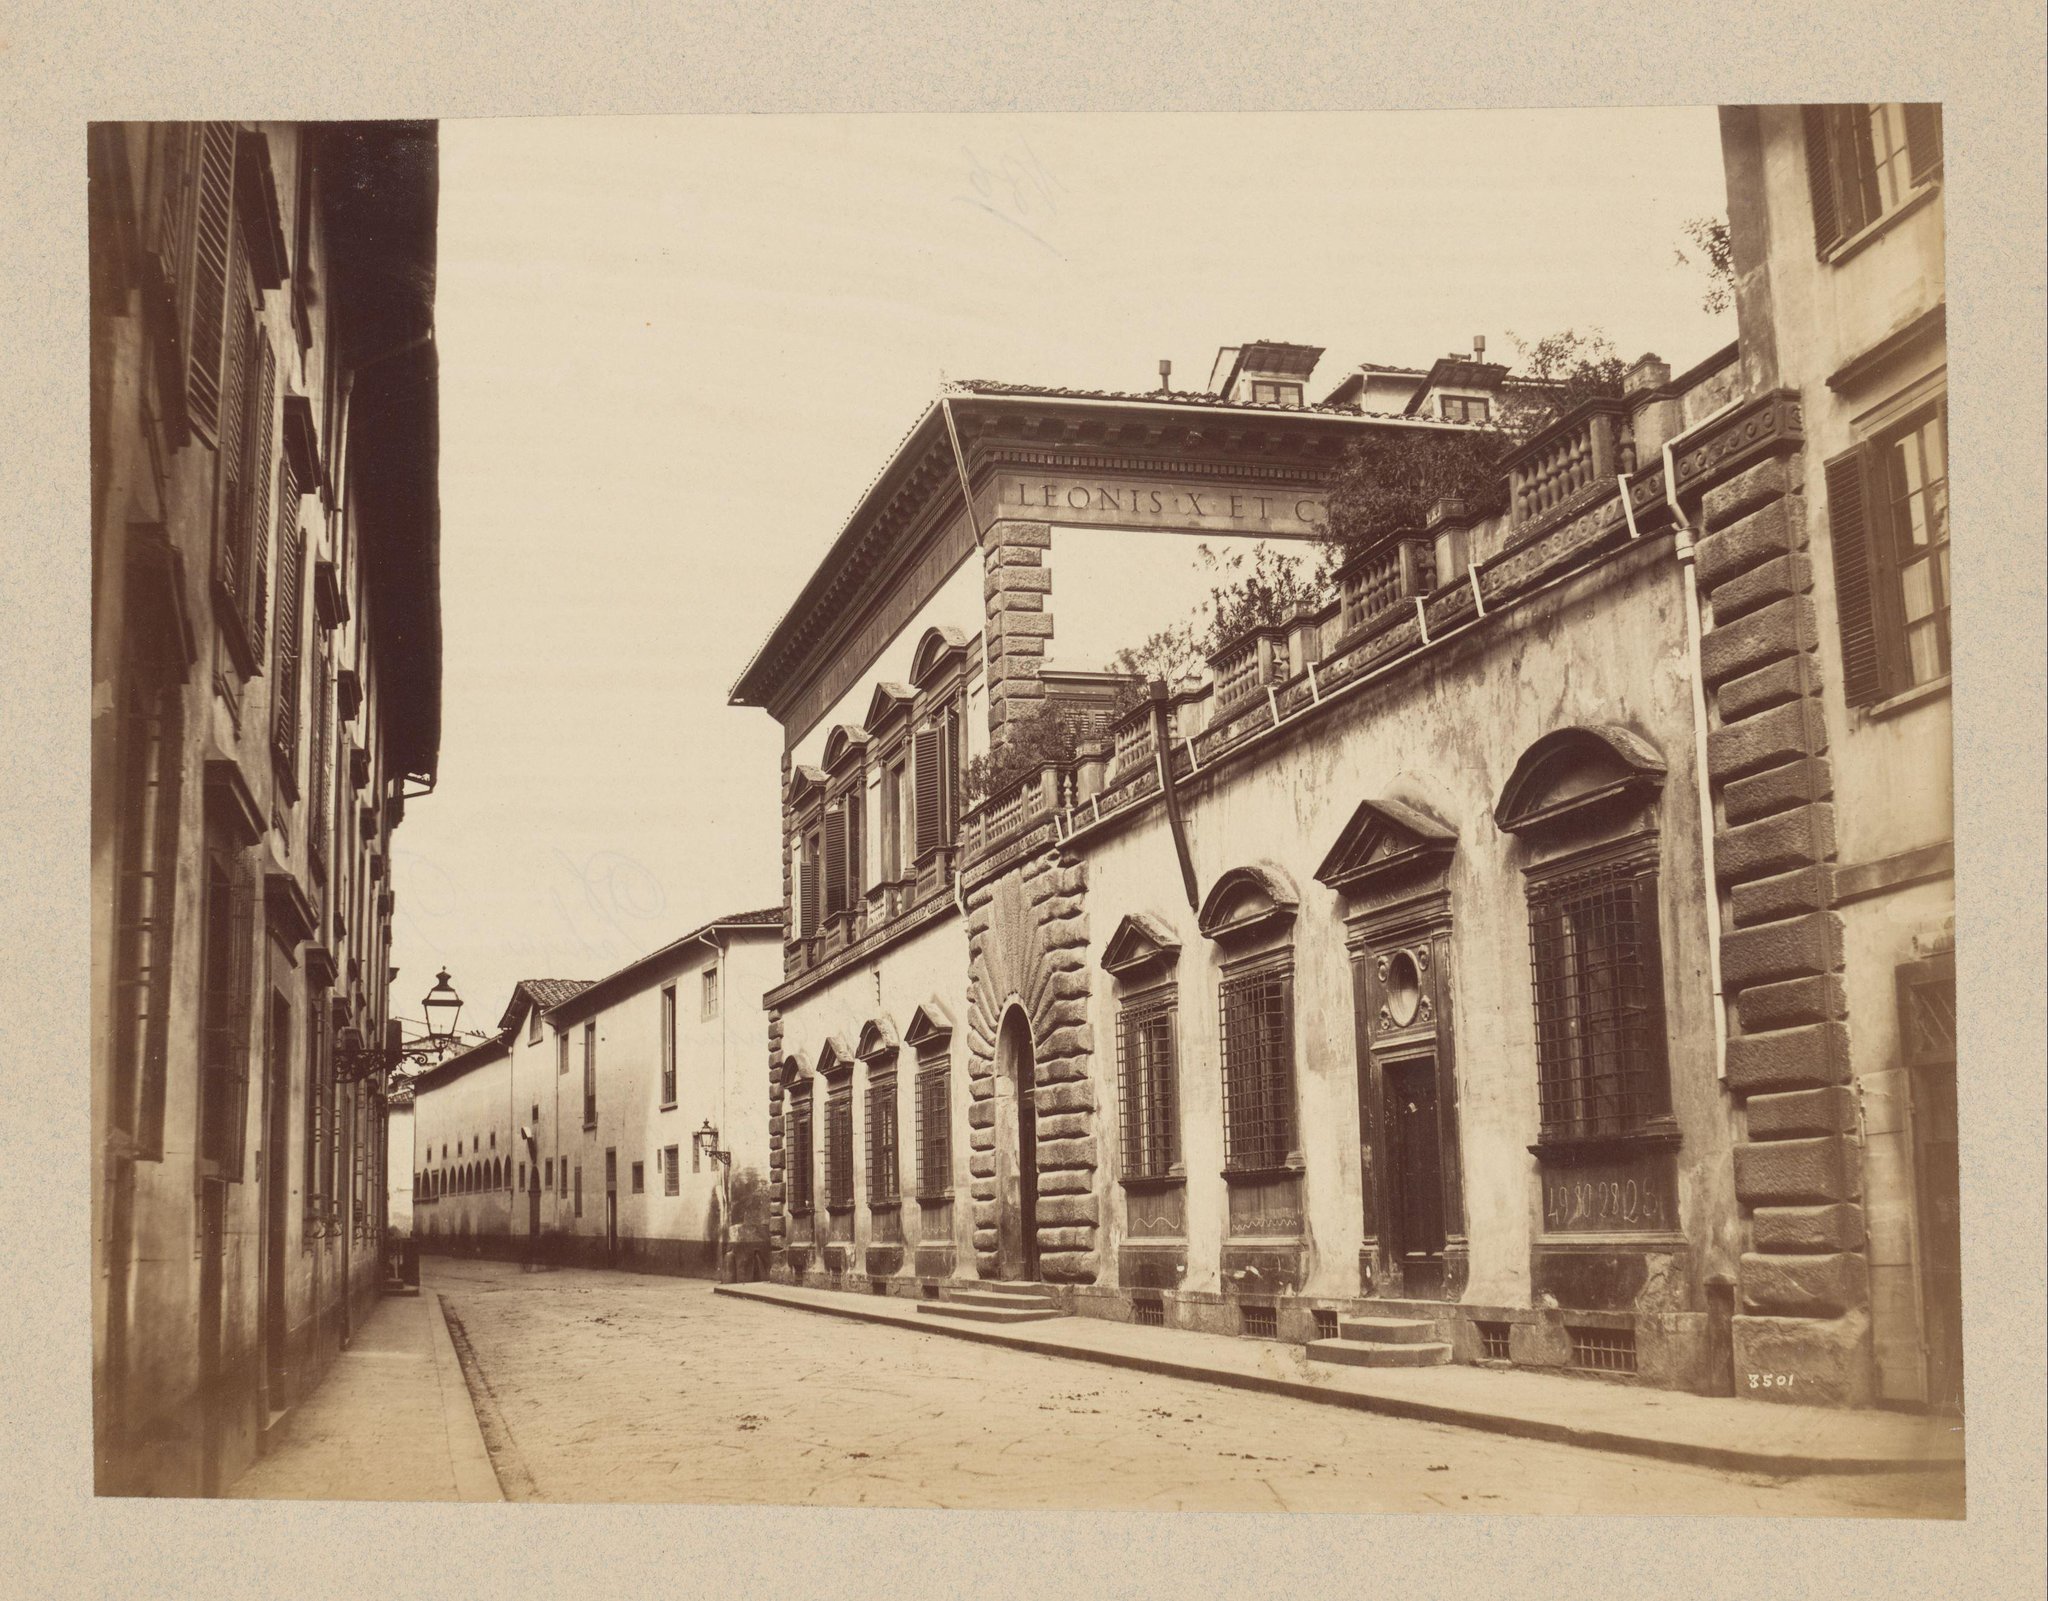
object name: photograph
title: Gezicht op een straat in Florence (?)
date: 1865-1900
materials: cardboard, photographic support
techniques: albumen print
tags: bologna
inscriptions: signature: ‘ALINARI’, : ‘3501’